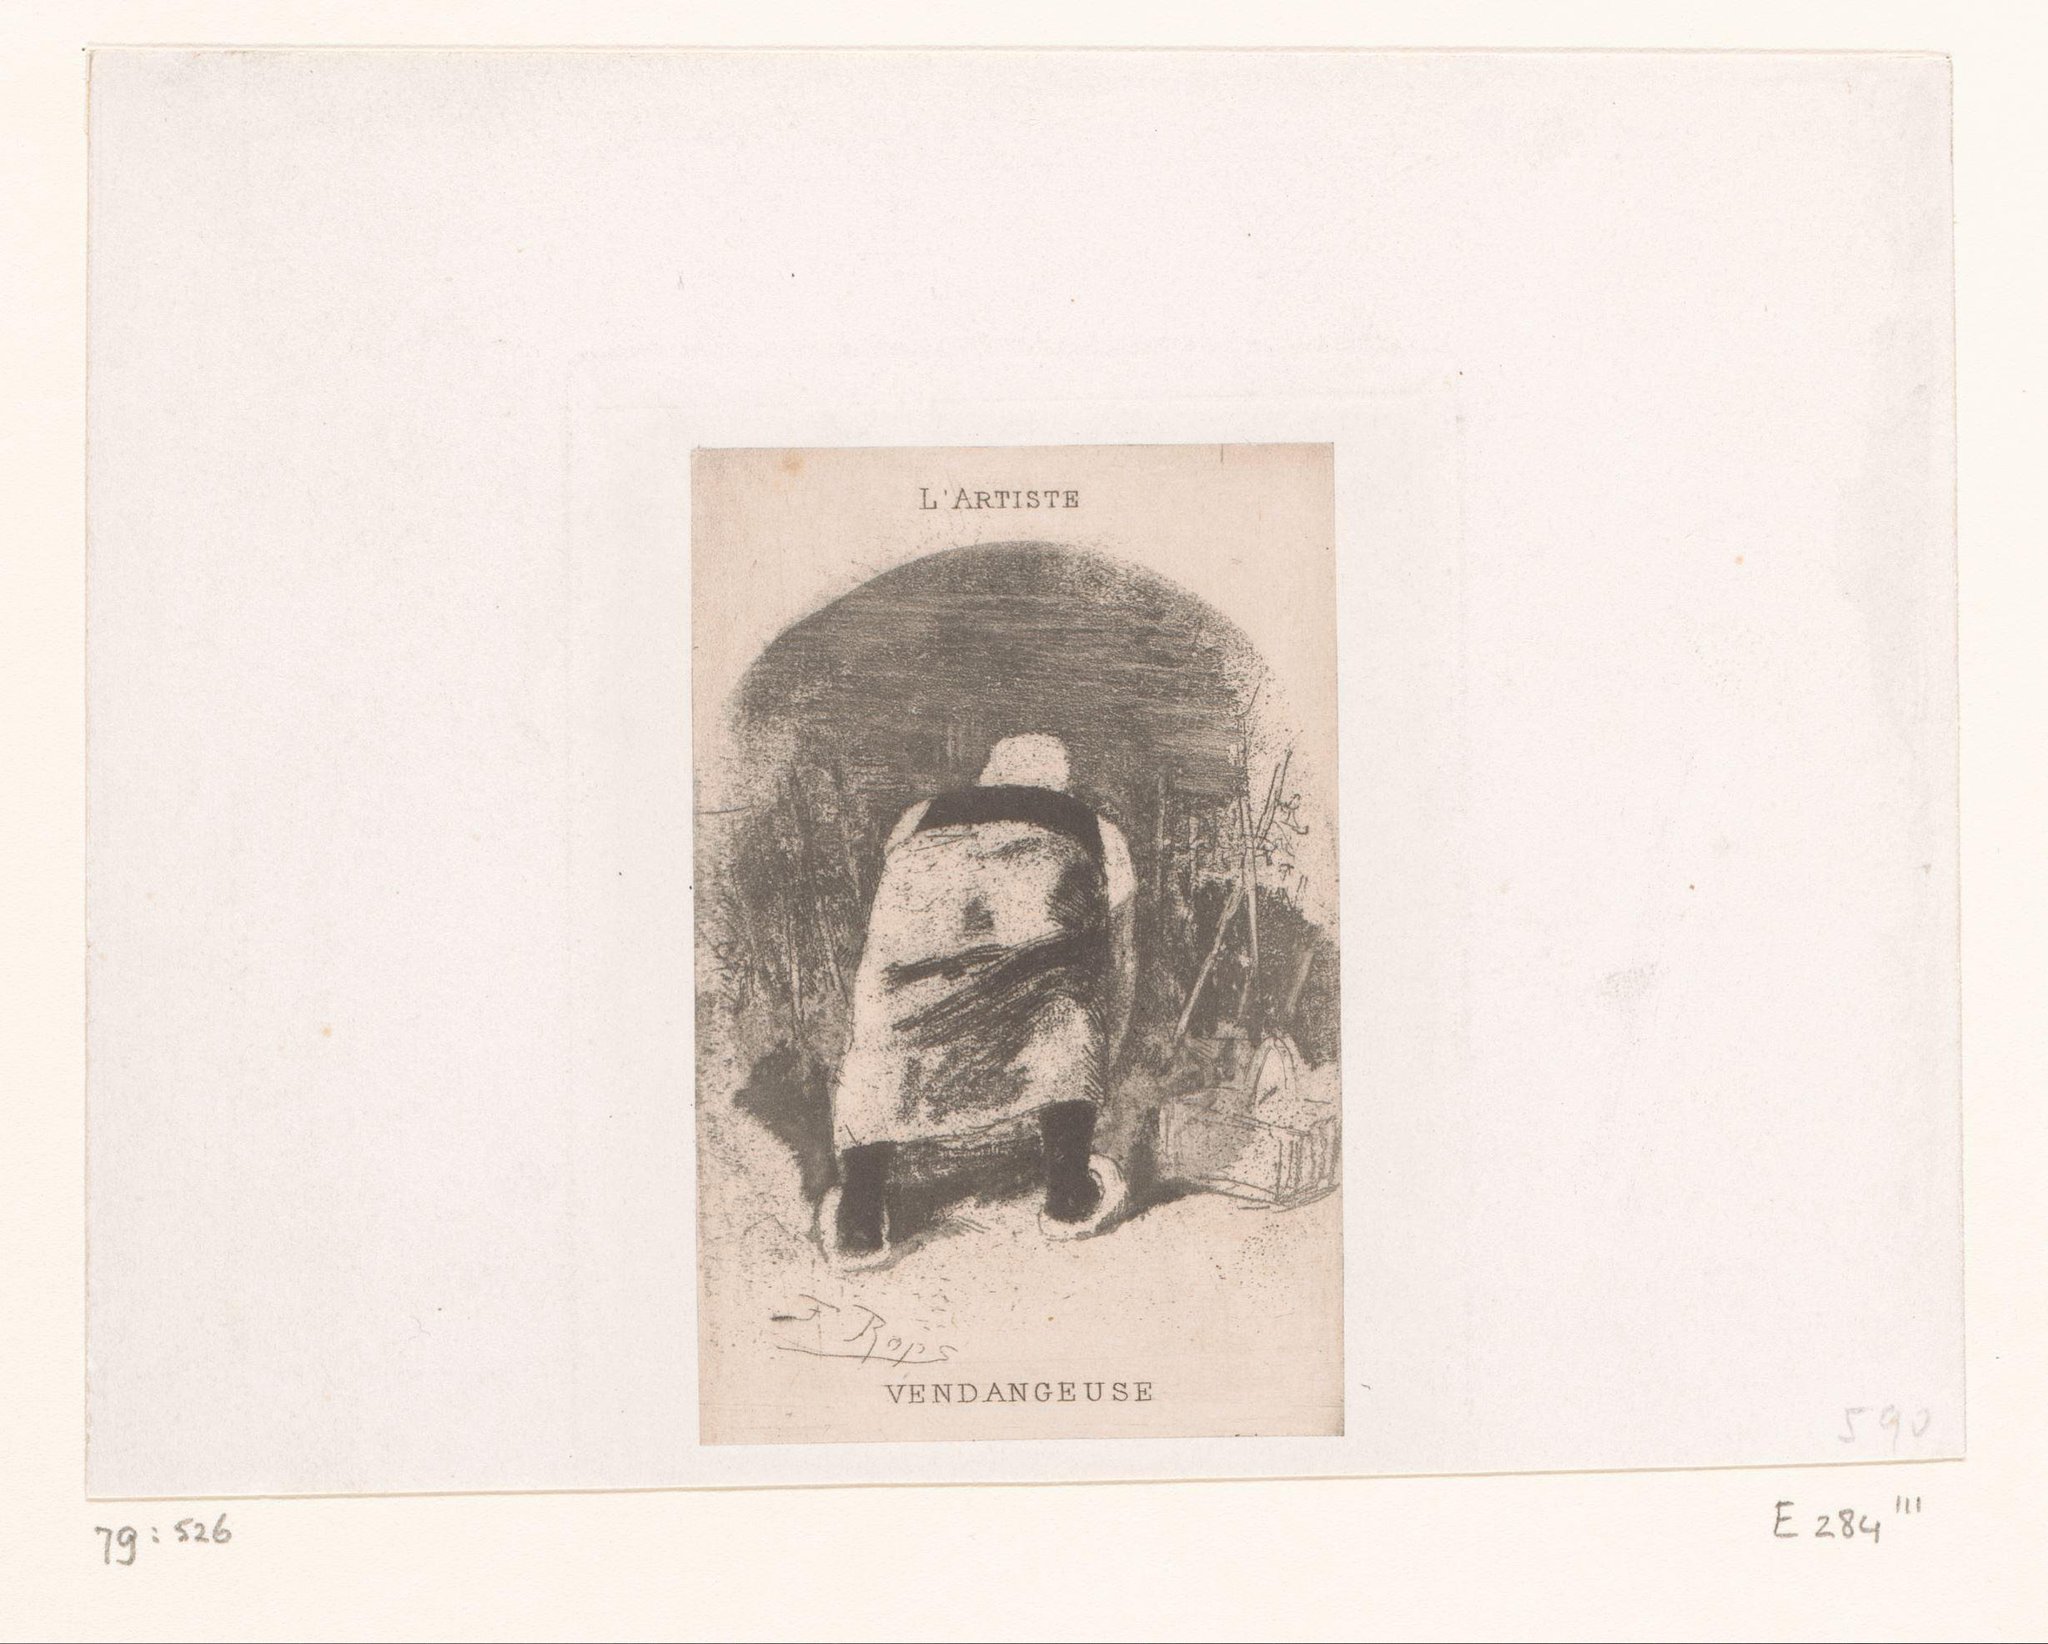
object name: print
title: Vendangeuse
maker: félicien rops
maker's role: draughtsman, print maker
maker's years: 1833-1898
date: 1888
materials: paper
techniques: drypoint, soft ground etching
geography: paris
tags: wine production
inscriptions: collector's mark: Lugt 2228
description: Prent gepubliceerd in: L'Artiste: journal de la littérature et des beaux-arts (1888).